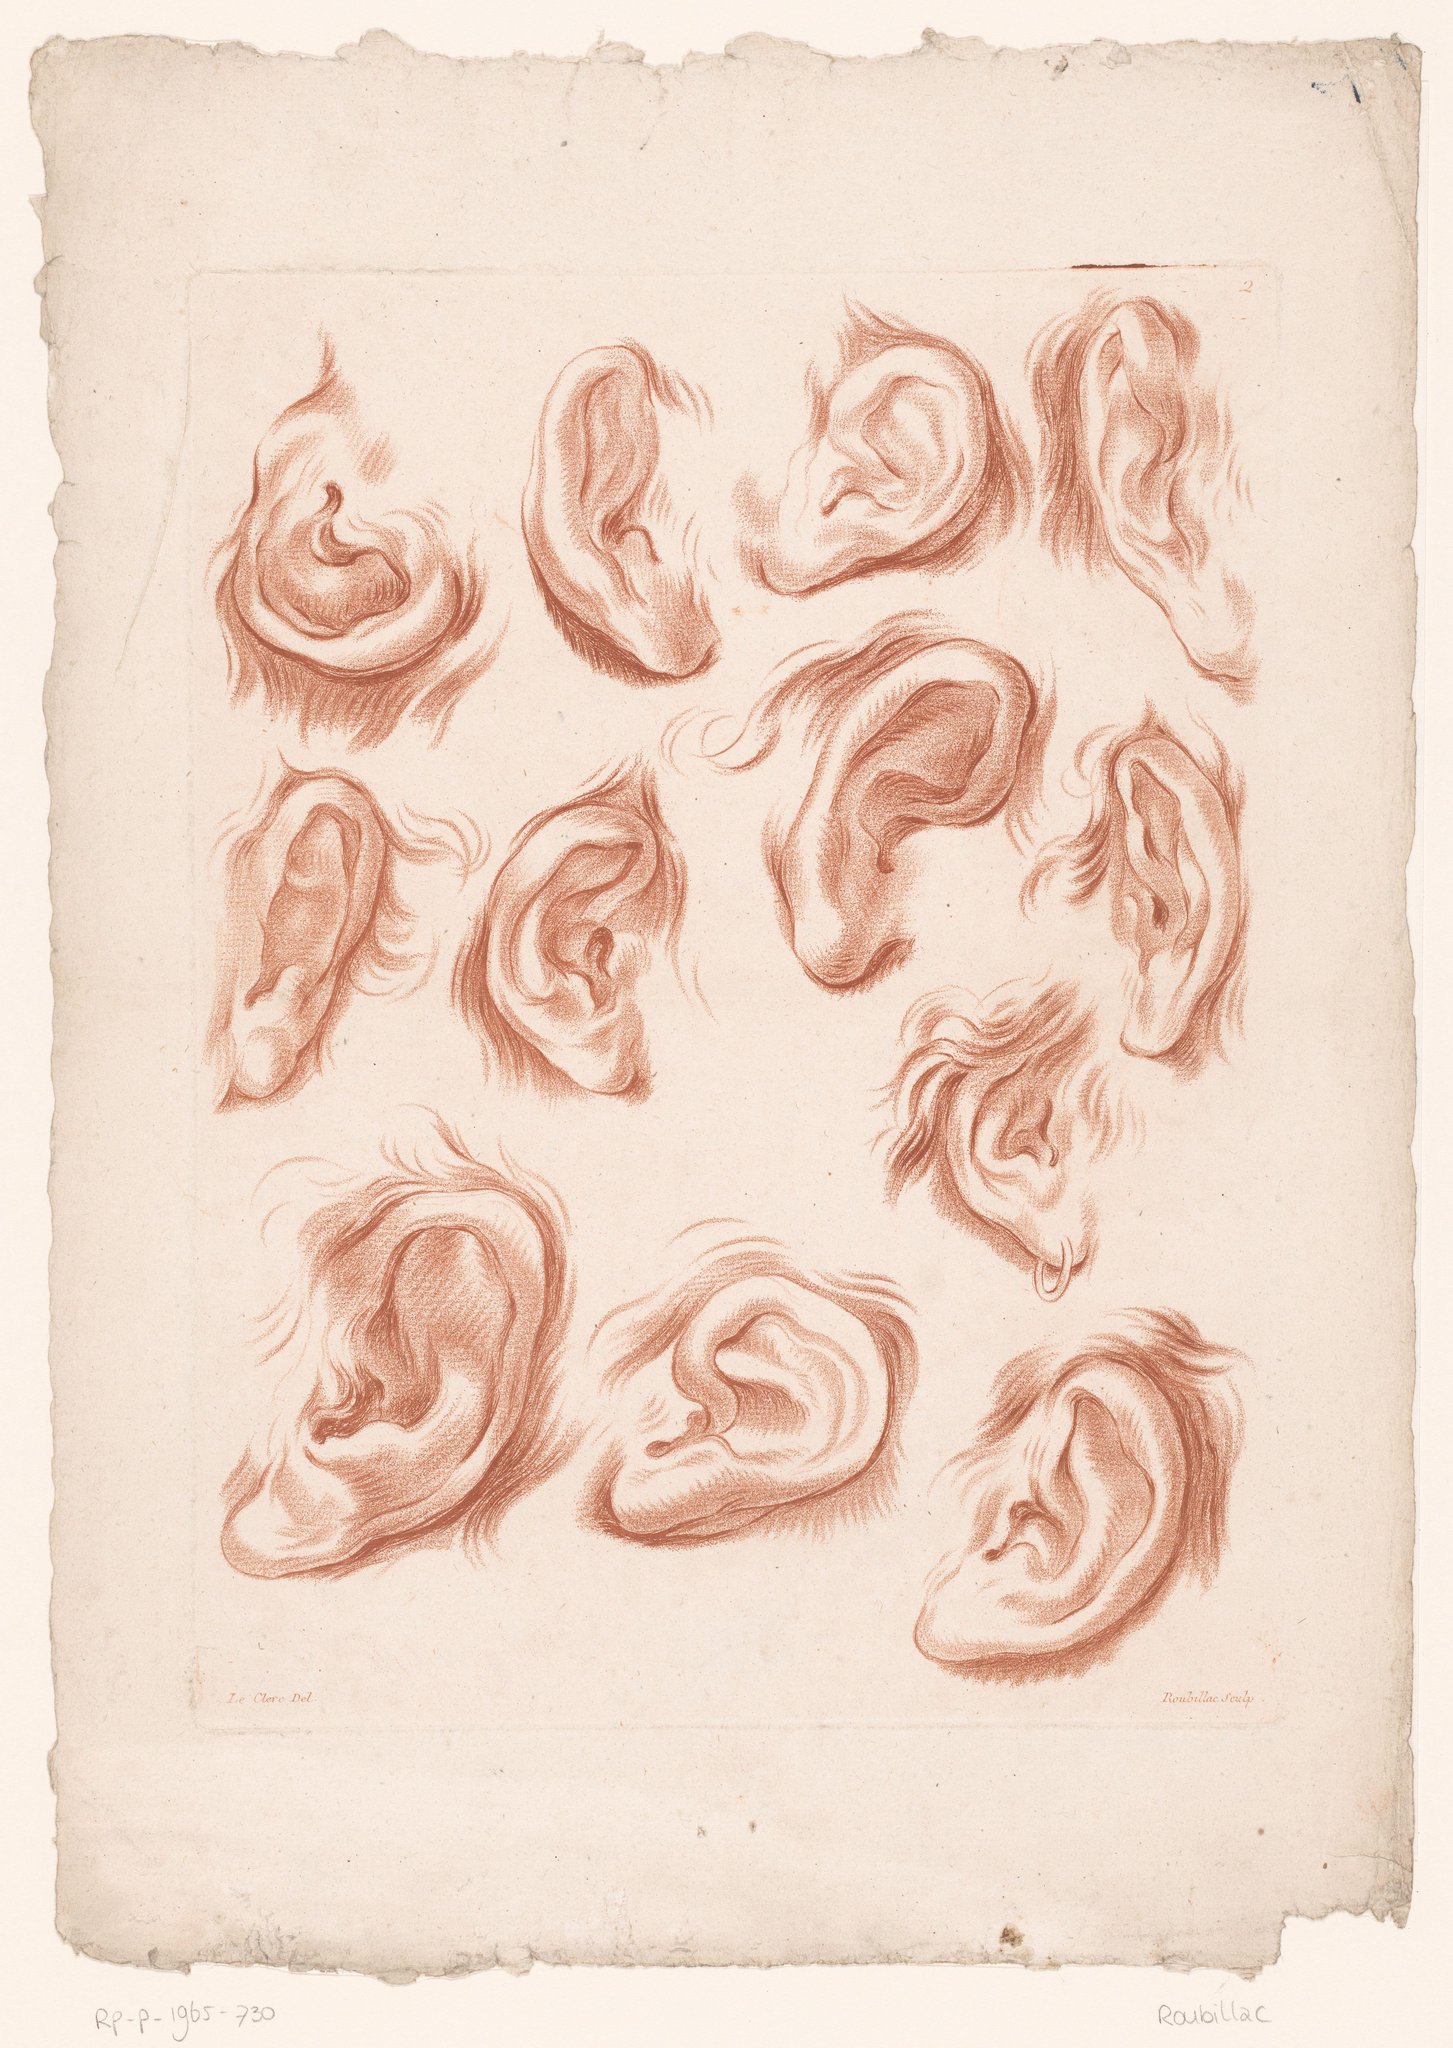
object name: print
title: Principes van het tekenen naar de natuur, deel één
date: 1784-1796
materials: paper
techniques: printmaking, etching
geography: paris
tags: drawing, sketch, ears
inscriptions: collector's mark: Lugt 2228